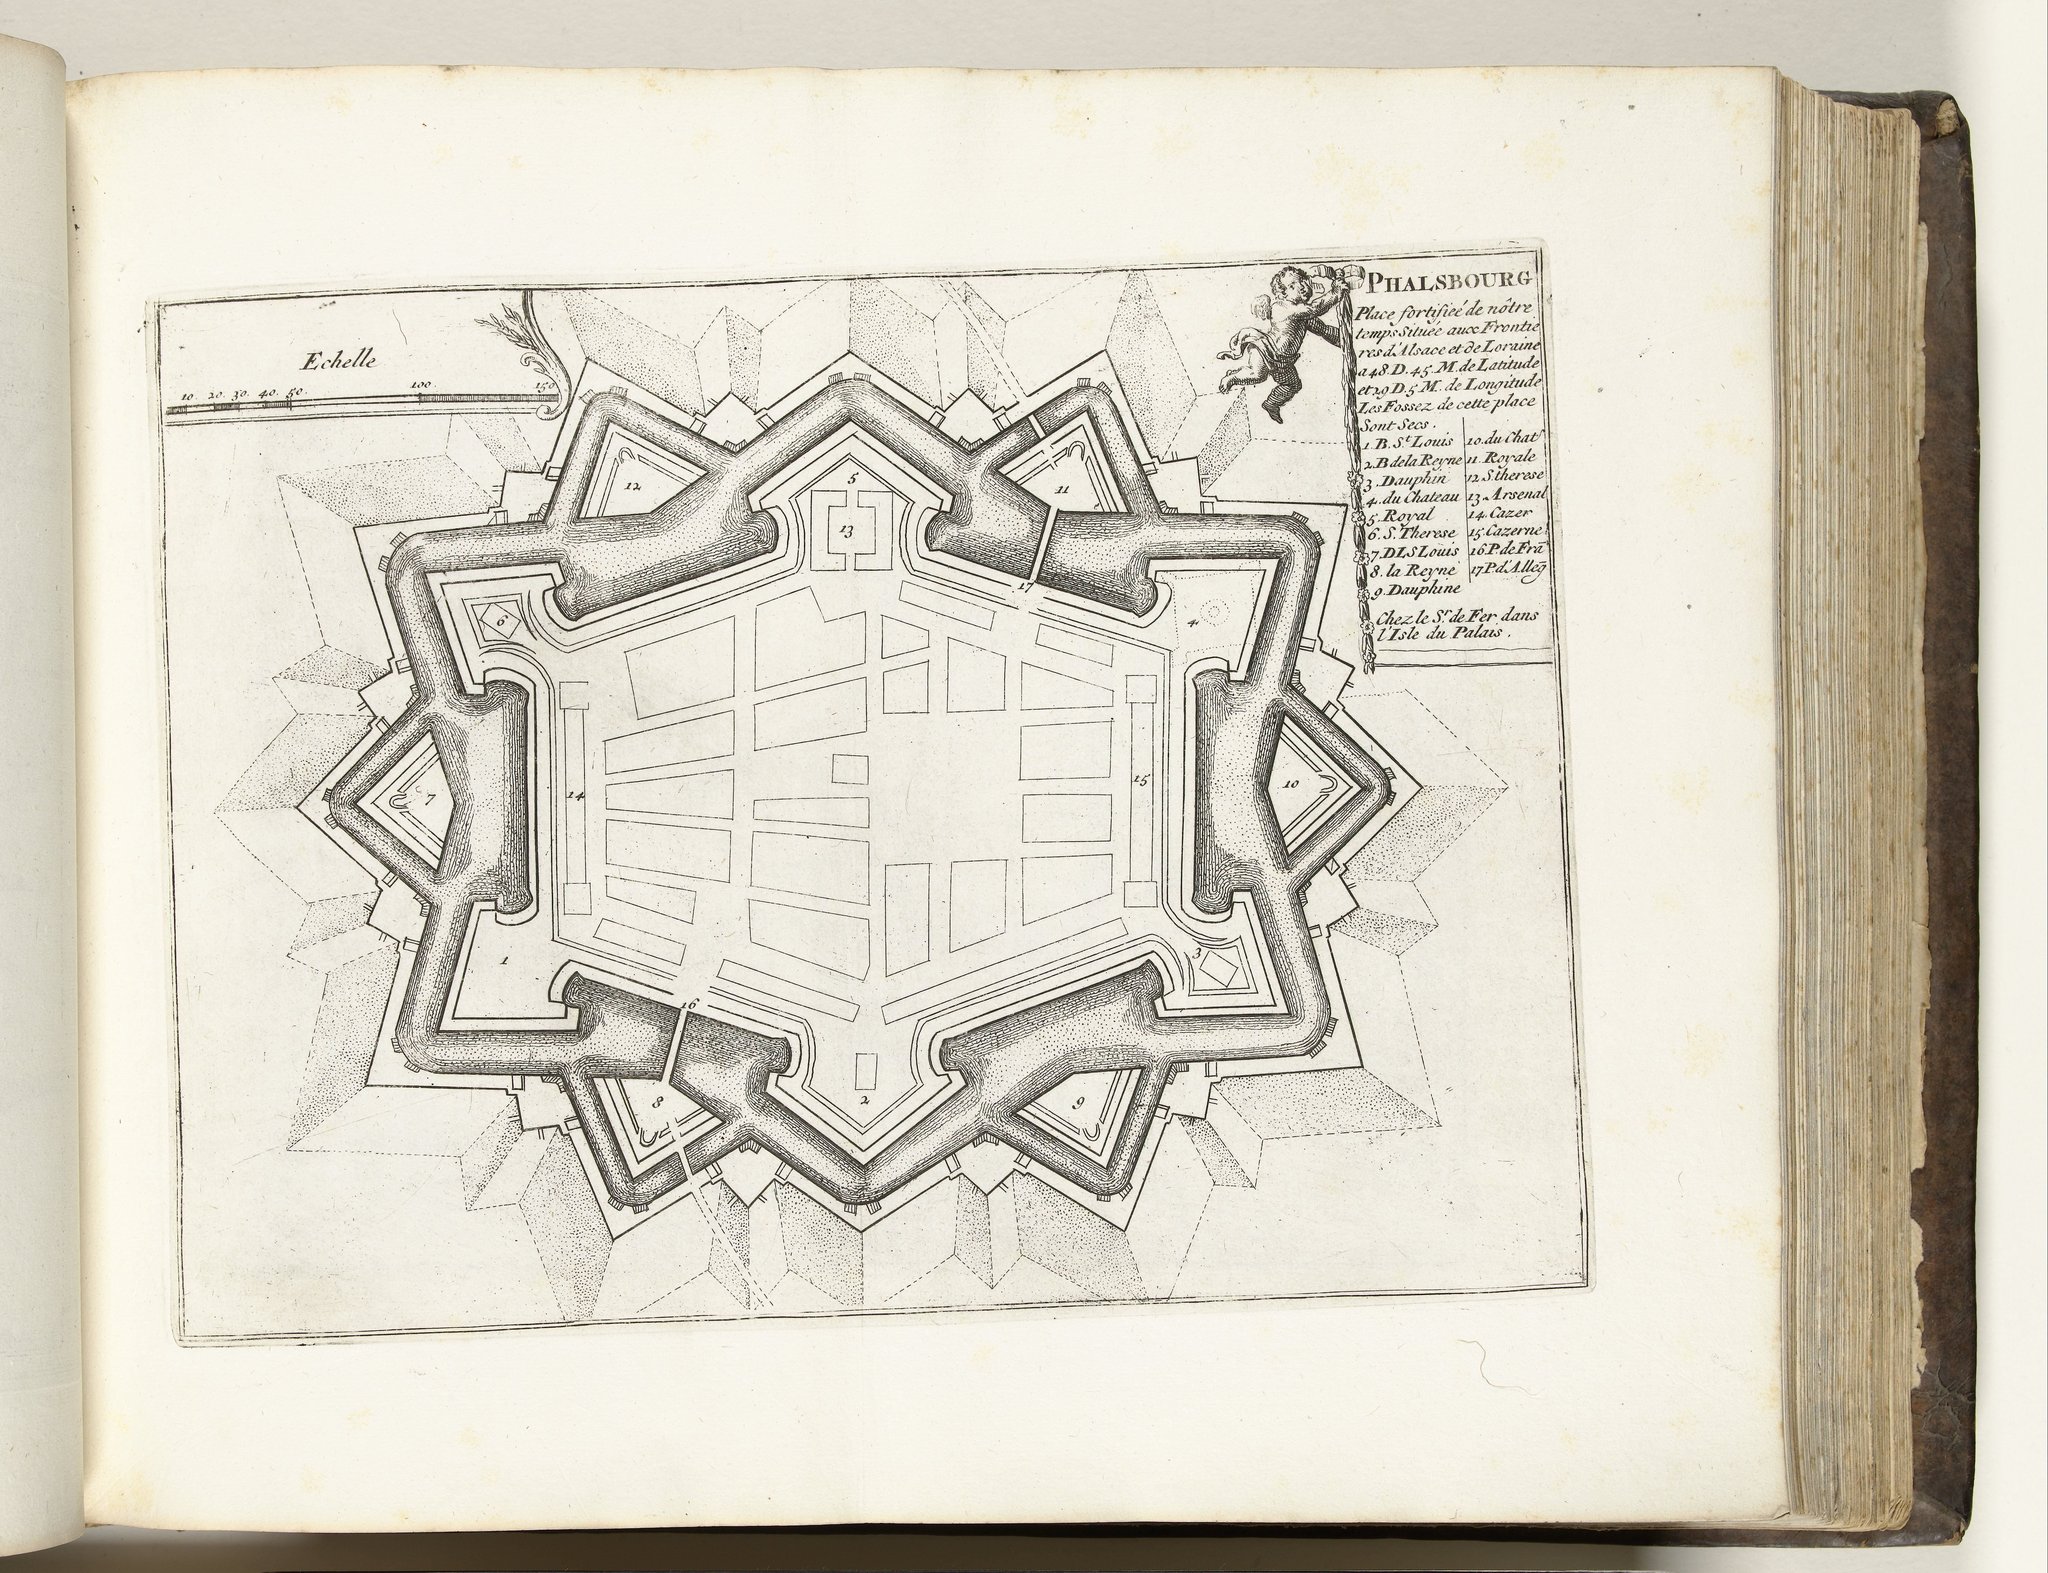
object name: print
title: Les forces de l'Europe, ou description des principales villes, avec leurs fortifications : dessignées par les meilleurs ingenieurs, particulierement celles (...) de la France, dont les plans ont esté levez par M. de Vauban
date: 1695-1697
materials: paper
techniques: etching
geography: paris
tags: fortress, maps of cities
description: Plattegrond van de versterkingen om de Franse stad Phalsbourg. Onderdeel van het vierde deel (1697) van het prentwerk waarin gebundeld zijn de acht delen van Les forces de l'Europe uitgegeven tussen 1693-1697. Het prentwerk bestaat uit 175 platen met plannen (afkomstig van Sébastien Le Prestre, Seigneur de Vauban) van vermaarde sterke steden en vestingen in de Negenjarige Oorlog. Titel en opschriften in het Frans.